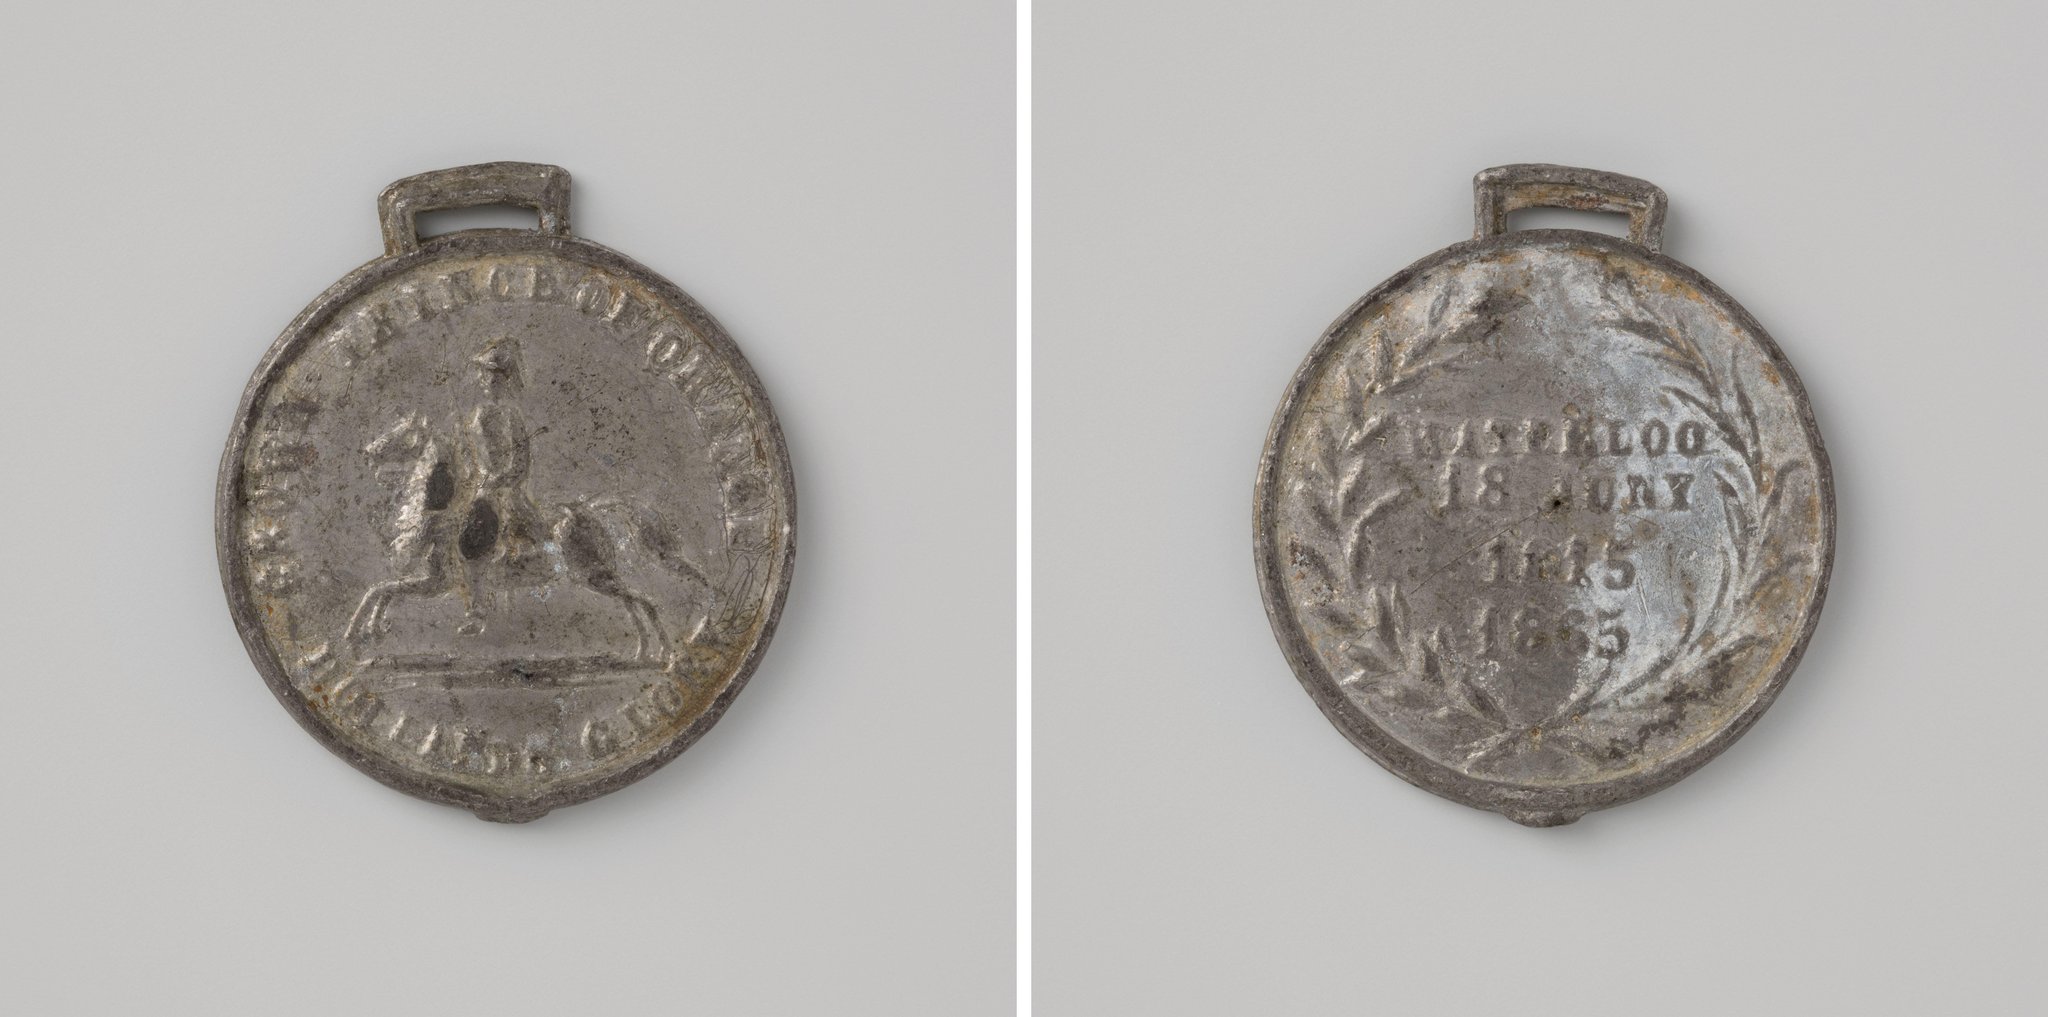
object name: history medal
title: Vijftigjarige herdenking van de rol van de Prins van Oranje in de Slag bij Waterloo 1815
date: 1865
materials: tin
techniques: striking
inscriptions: inscription: ‘WATERLOO / 18 JUNY / 1815 / 1865’, circumscription: ‘CROWN PRINCE OF ORANGE / HOLLANDS GRORY’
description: Gegoten tinnen penninkje met breed draagoog, op de voorzijde een ruiter naar links met Engelstalig omschrift, op de keerzijde vier regels tekst tussen gekruiste lauwer- en palmtakken.